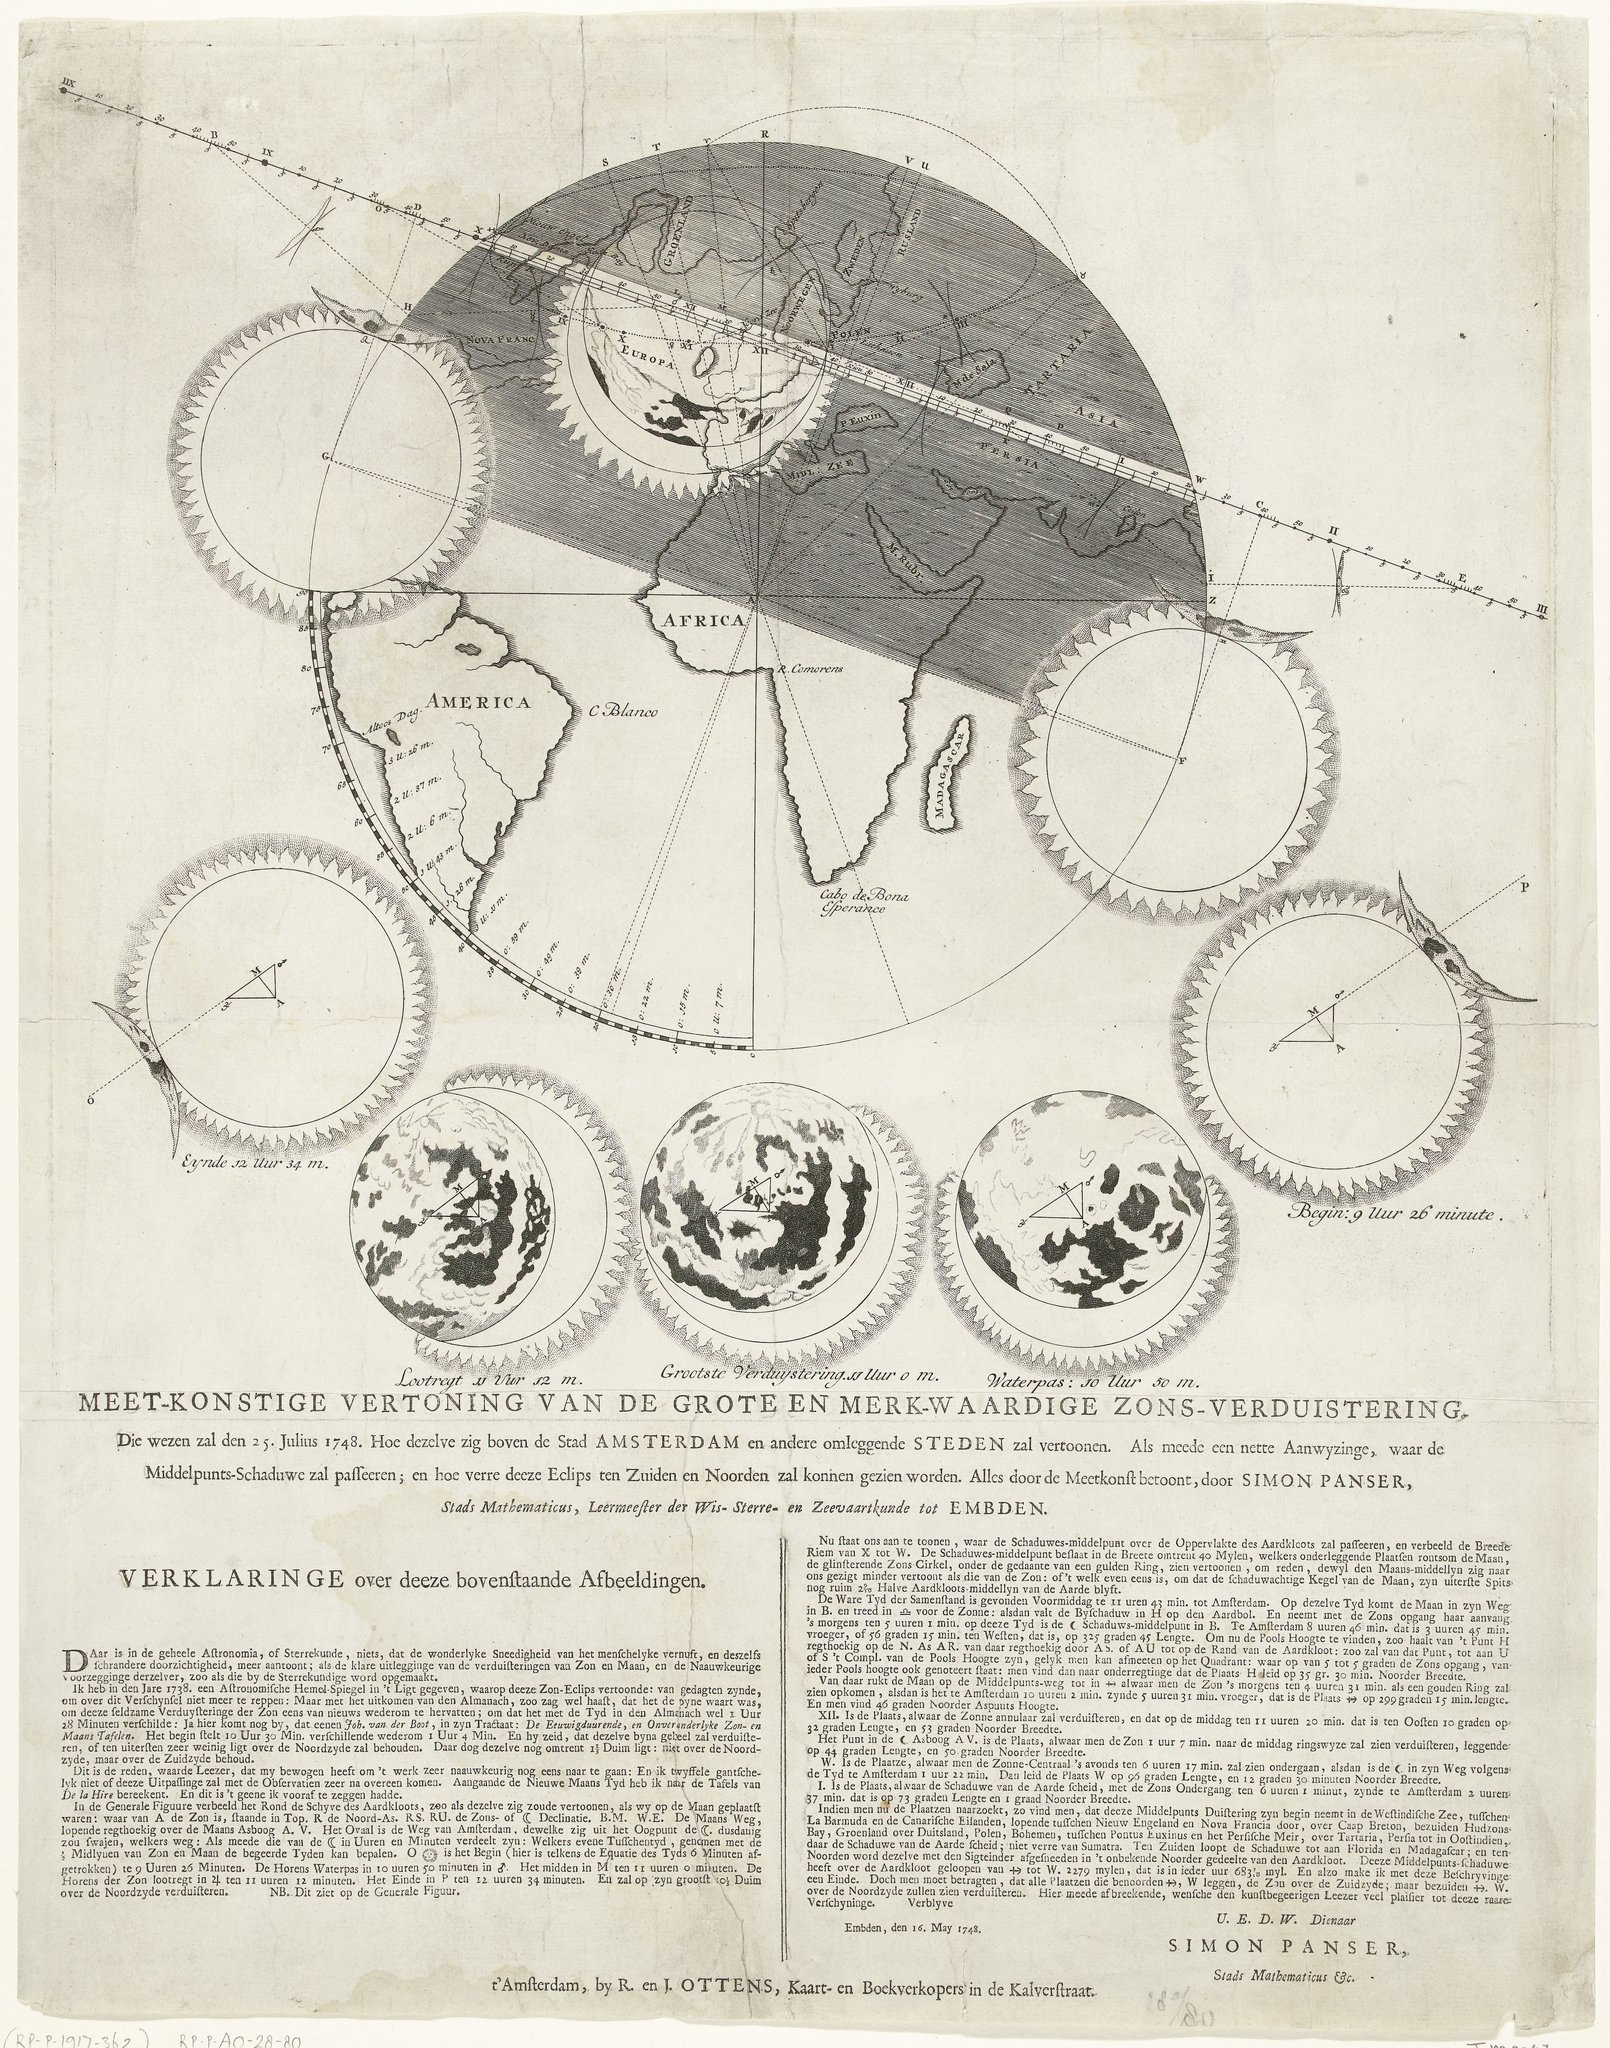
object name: print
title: Meet-konstig vertoning van de grote en merk-waardige zons-verduistering. Die wezen zal den 25. Julius 1748. Hoe dezelve zig boven de Stad Amsterdam en andere omleggende Steden zal vertoonen (...)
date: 1748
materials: paper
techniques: etching, letterpress printing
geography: emden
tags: solar eclipse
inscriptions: collector's mark: Lugt 2228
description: Astronomische voorstelling hoe de onvolledige zonsverduistering van 25 juli 1748 in Amsterdam en omringende plaatsen waarneembaar zal zijn en hoe het een schaduw op het noordelijk halfrond van de aarde zal werpen. Met verschillende stadia van de verduistering. Vastgeplakt onder de plaat een tekstblad met de titel en een verklaring van de voorstelling in twee kolommen door Simon Panser.